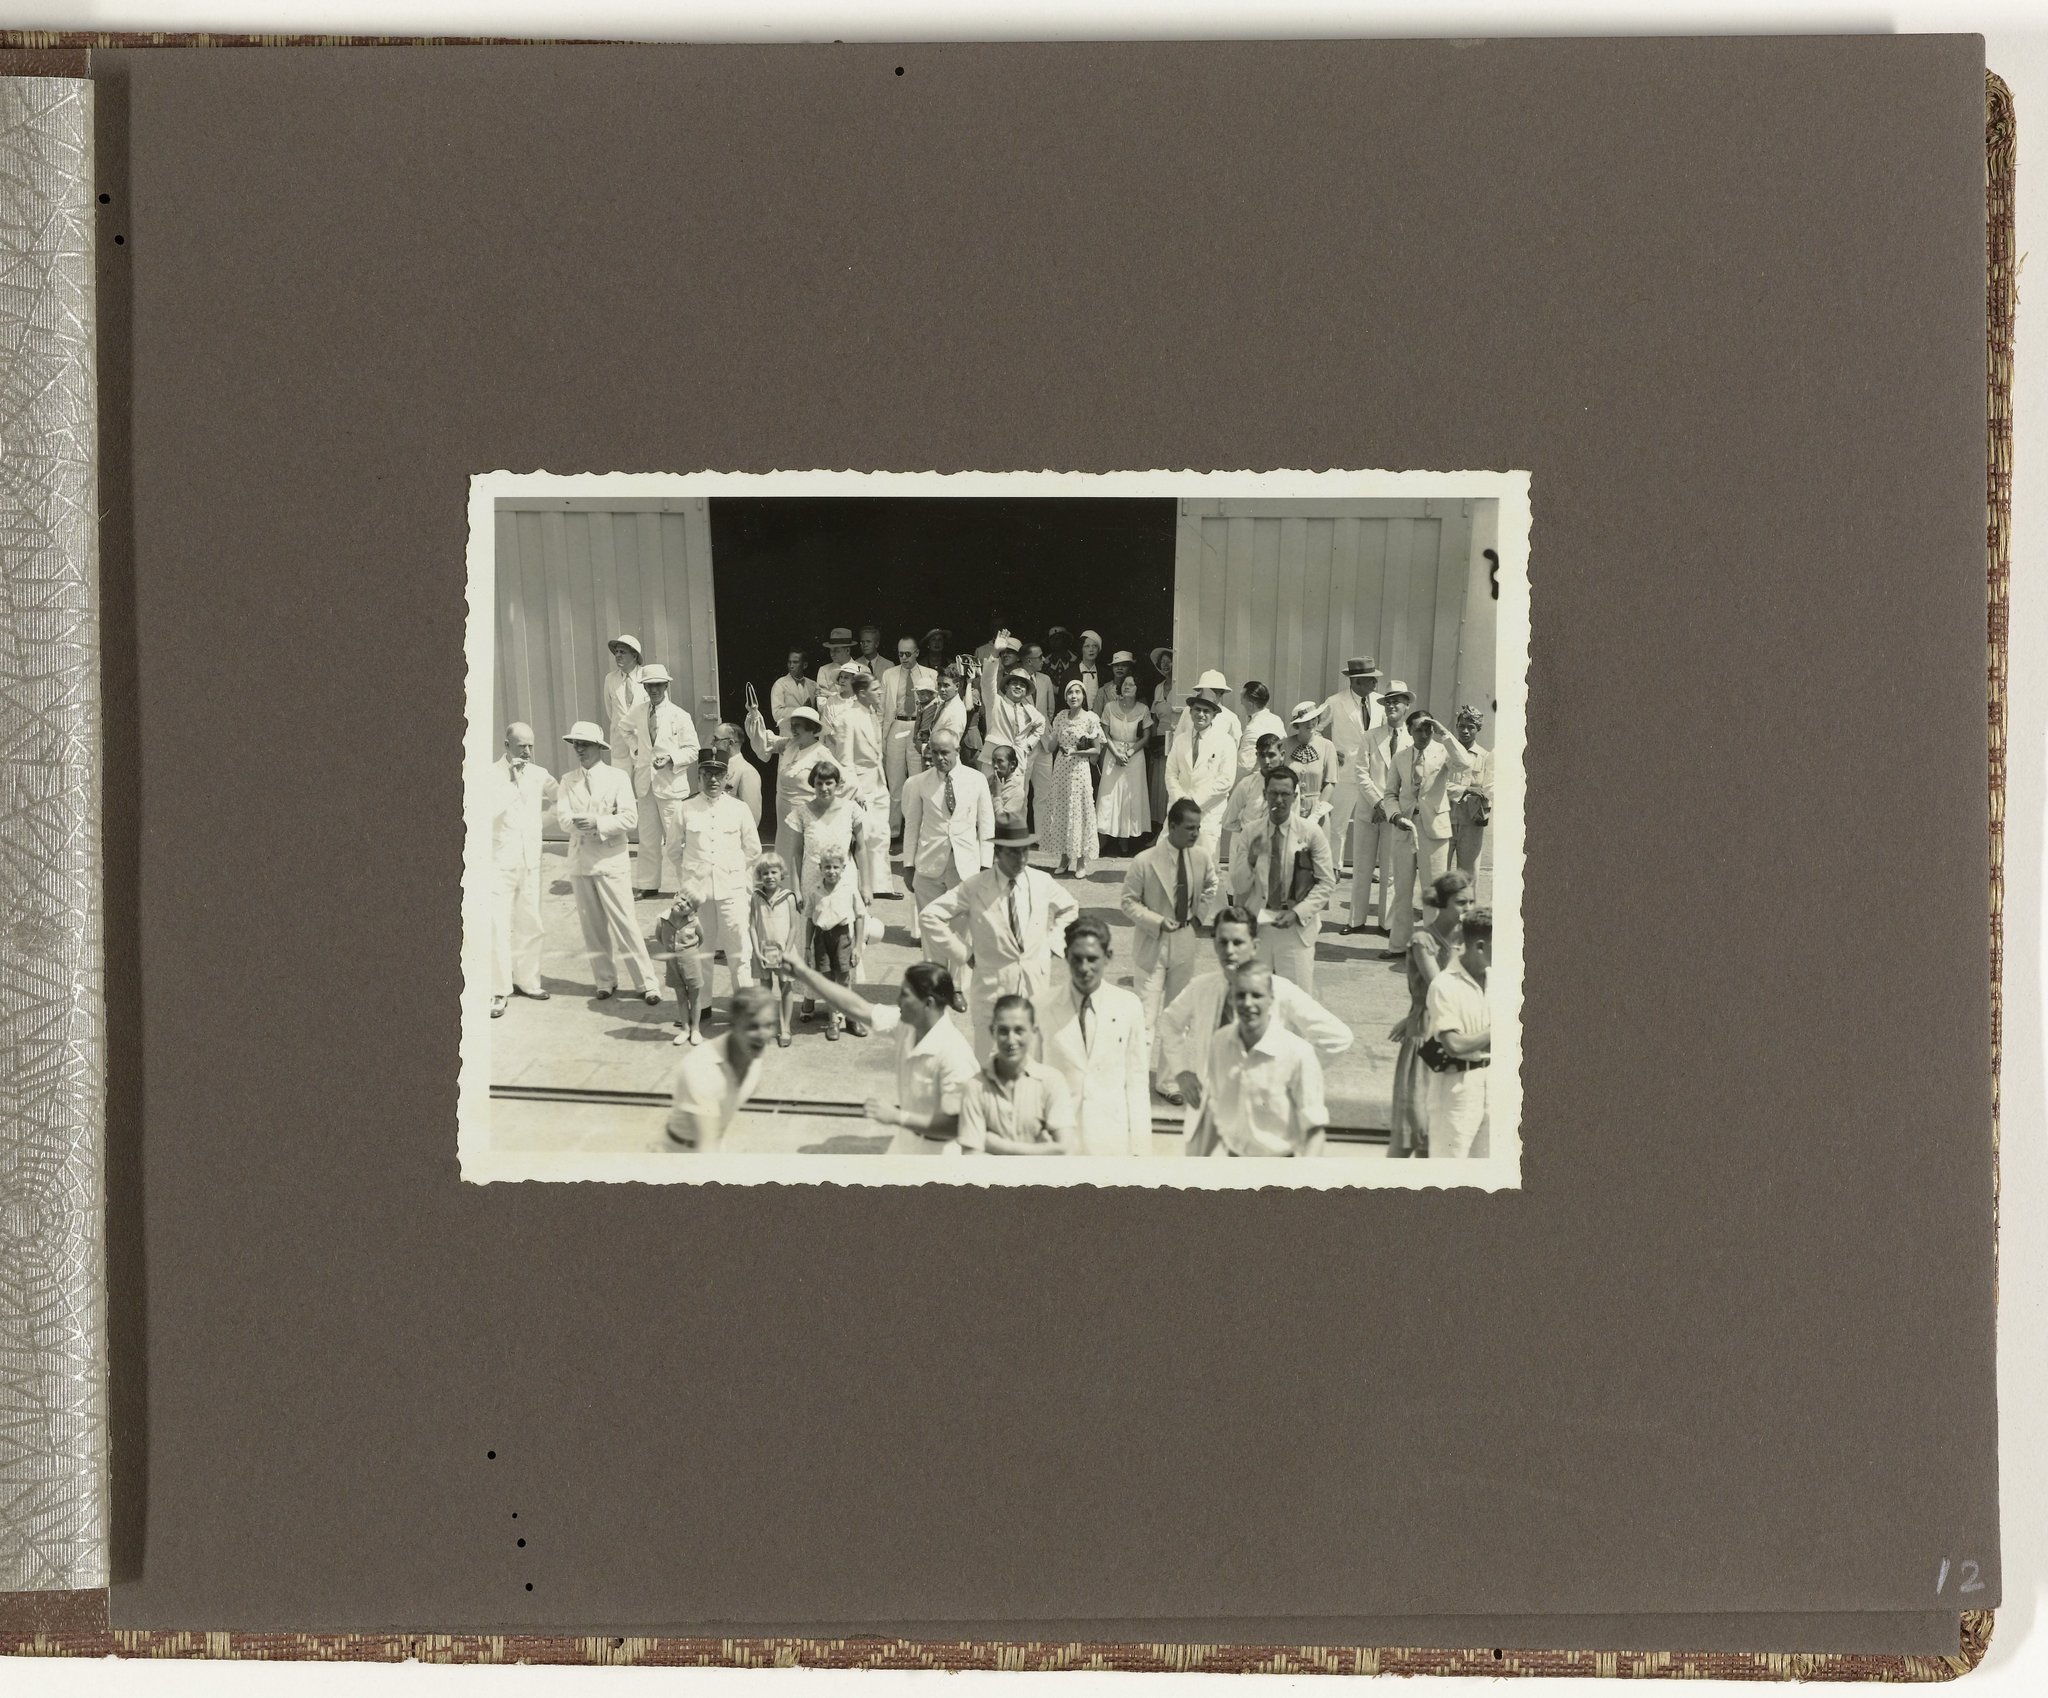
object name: photograph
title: Groepsfoto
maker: Anonymous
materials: photographic support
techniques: gelatin silver print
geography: batavia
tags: algebra and statistics, colonial government, anonymous historical persons portrayed in a group, in a group-portrait, batavia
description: In 1920 werd door de Directeur van Landbouw, Nijverheid en Handel een begin gemaakt met bundeling van statischtische werkzaamheden in één Statistisch Kantoor. In 1924 werd dit kantoor samengevoegd met statistiek van in- en uitvoer in het 'Centraal kantoor voor de Statistiek', gevestigd in Weltevreden, met prof. dr. J. van Gelderen als eerste directeur.